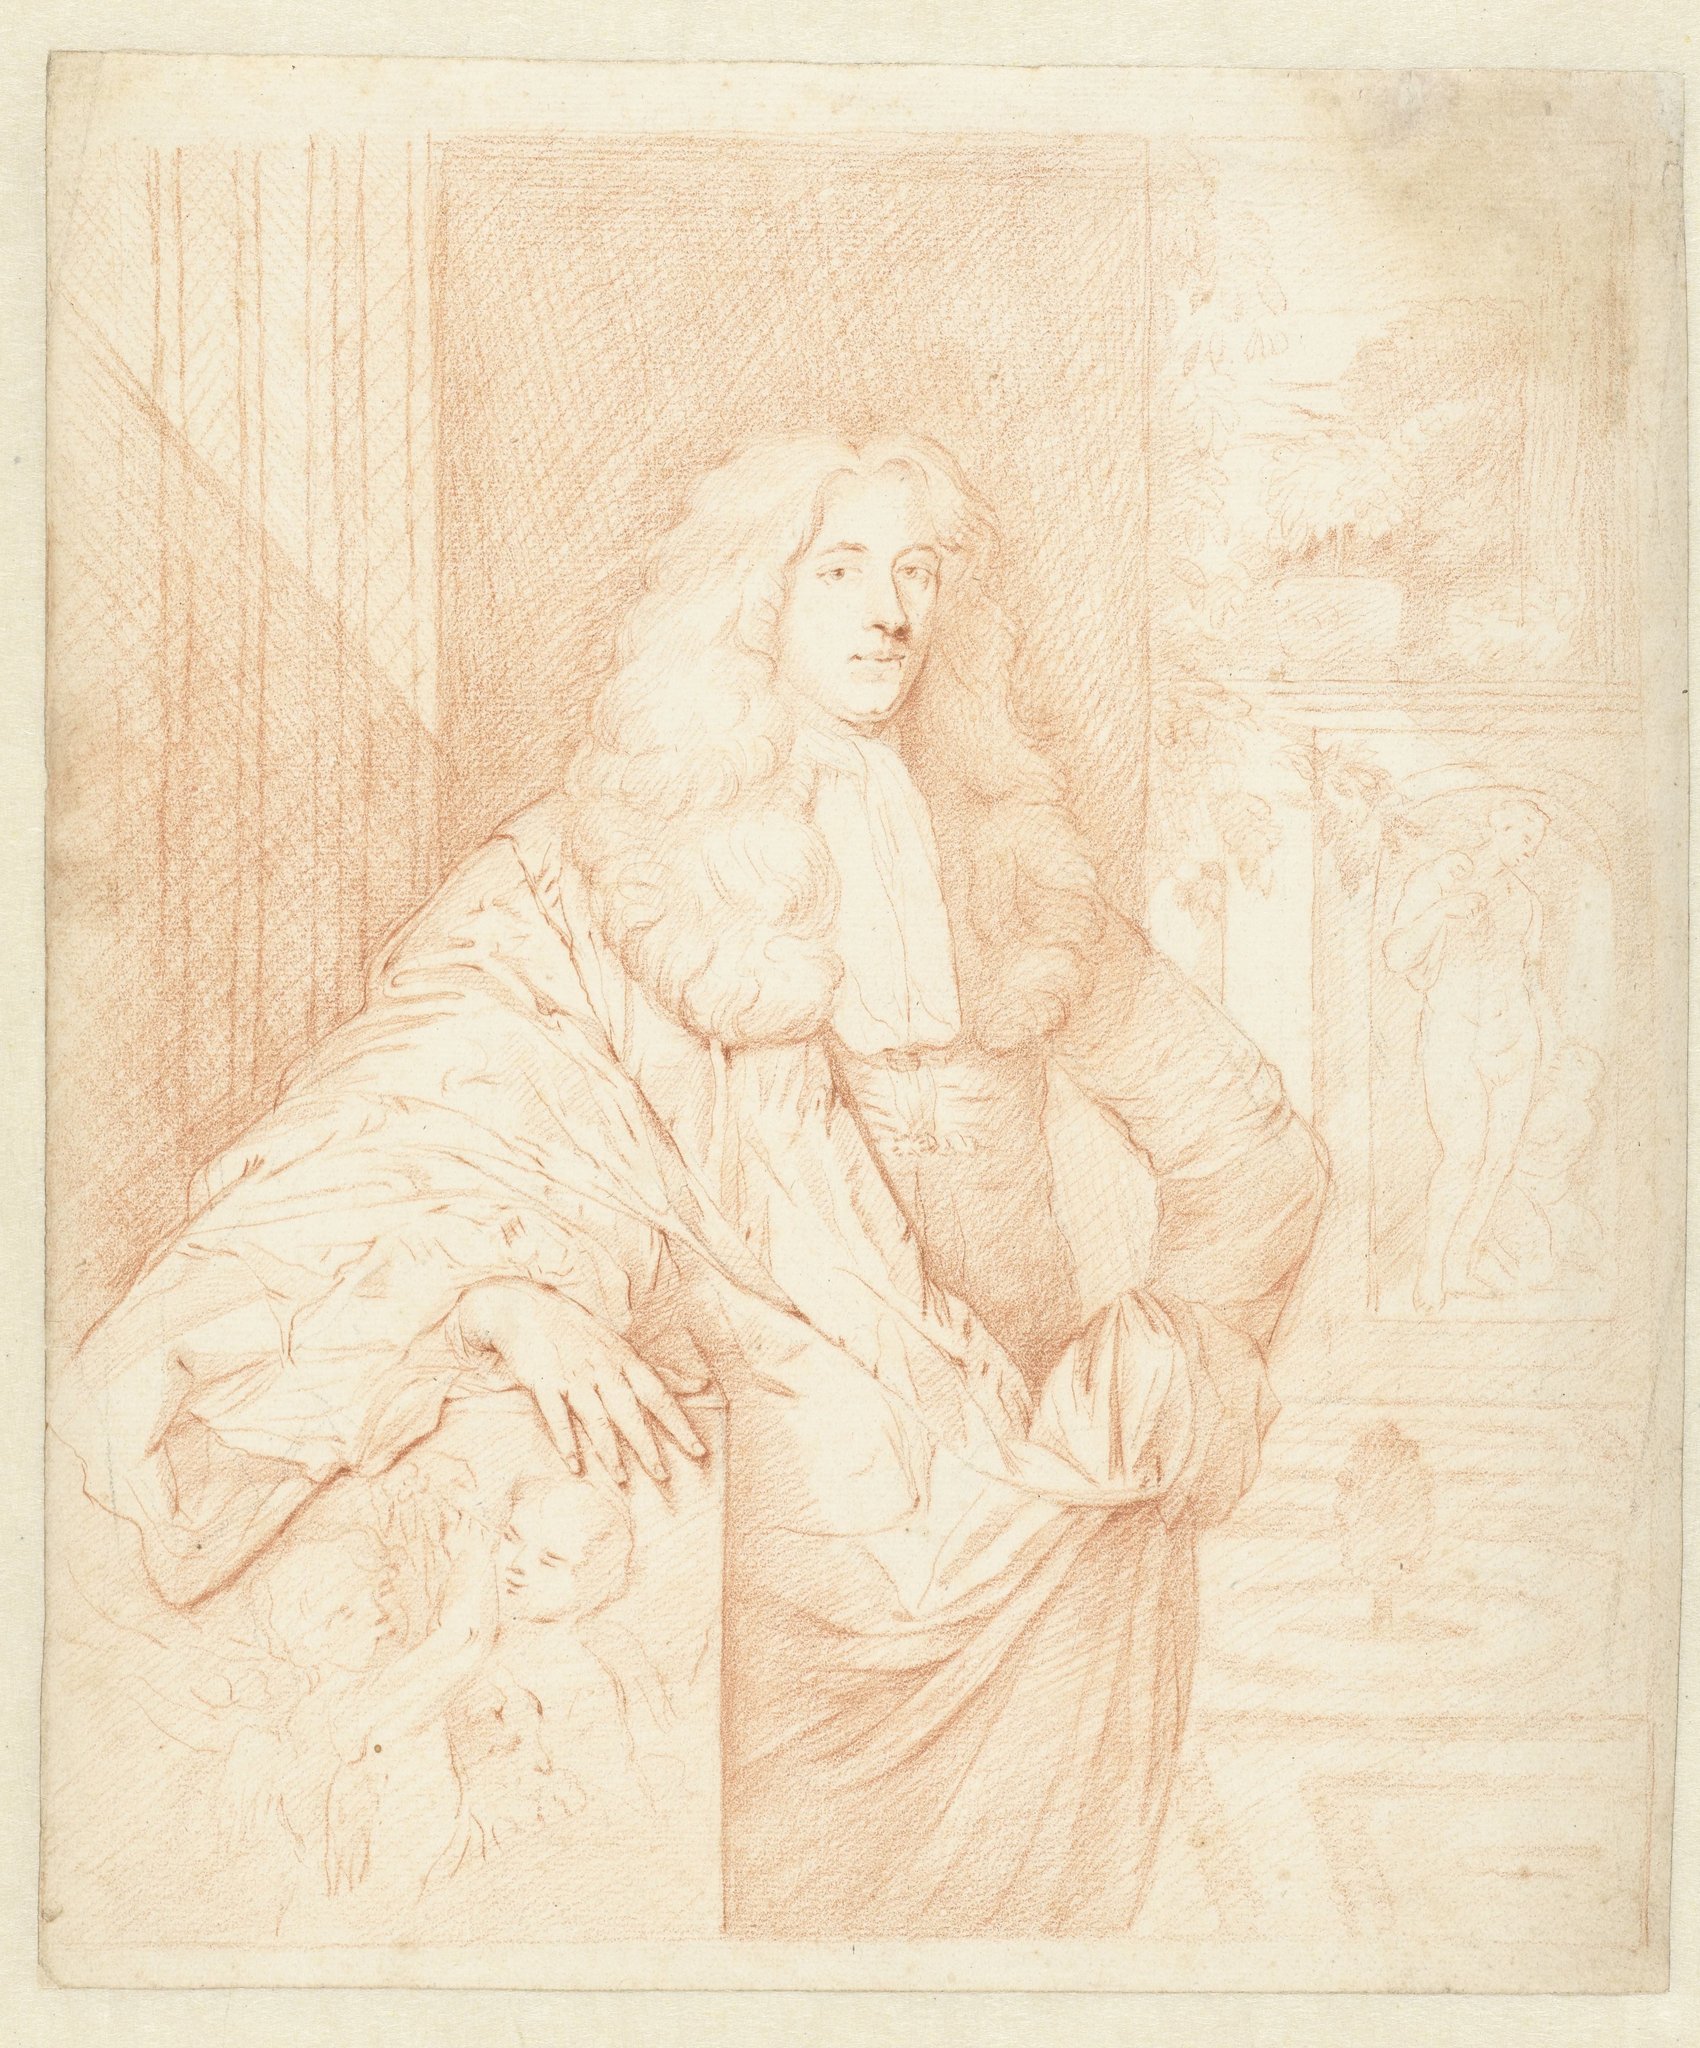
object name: drawing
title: Portret van een onbekende staande man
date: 1649-1684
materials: chalk, paper, pencil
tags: anonymous historical person portrayed alone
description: Kniestuk van een man met een lange pruik; de rechterarm op een balustrade met reliëf van putti, de linkerhand op de heup.